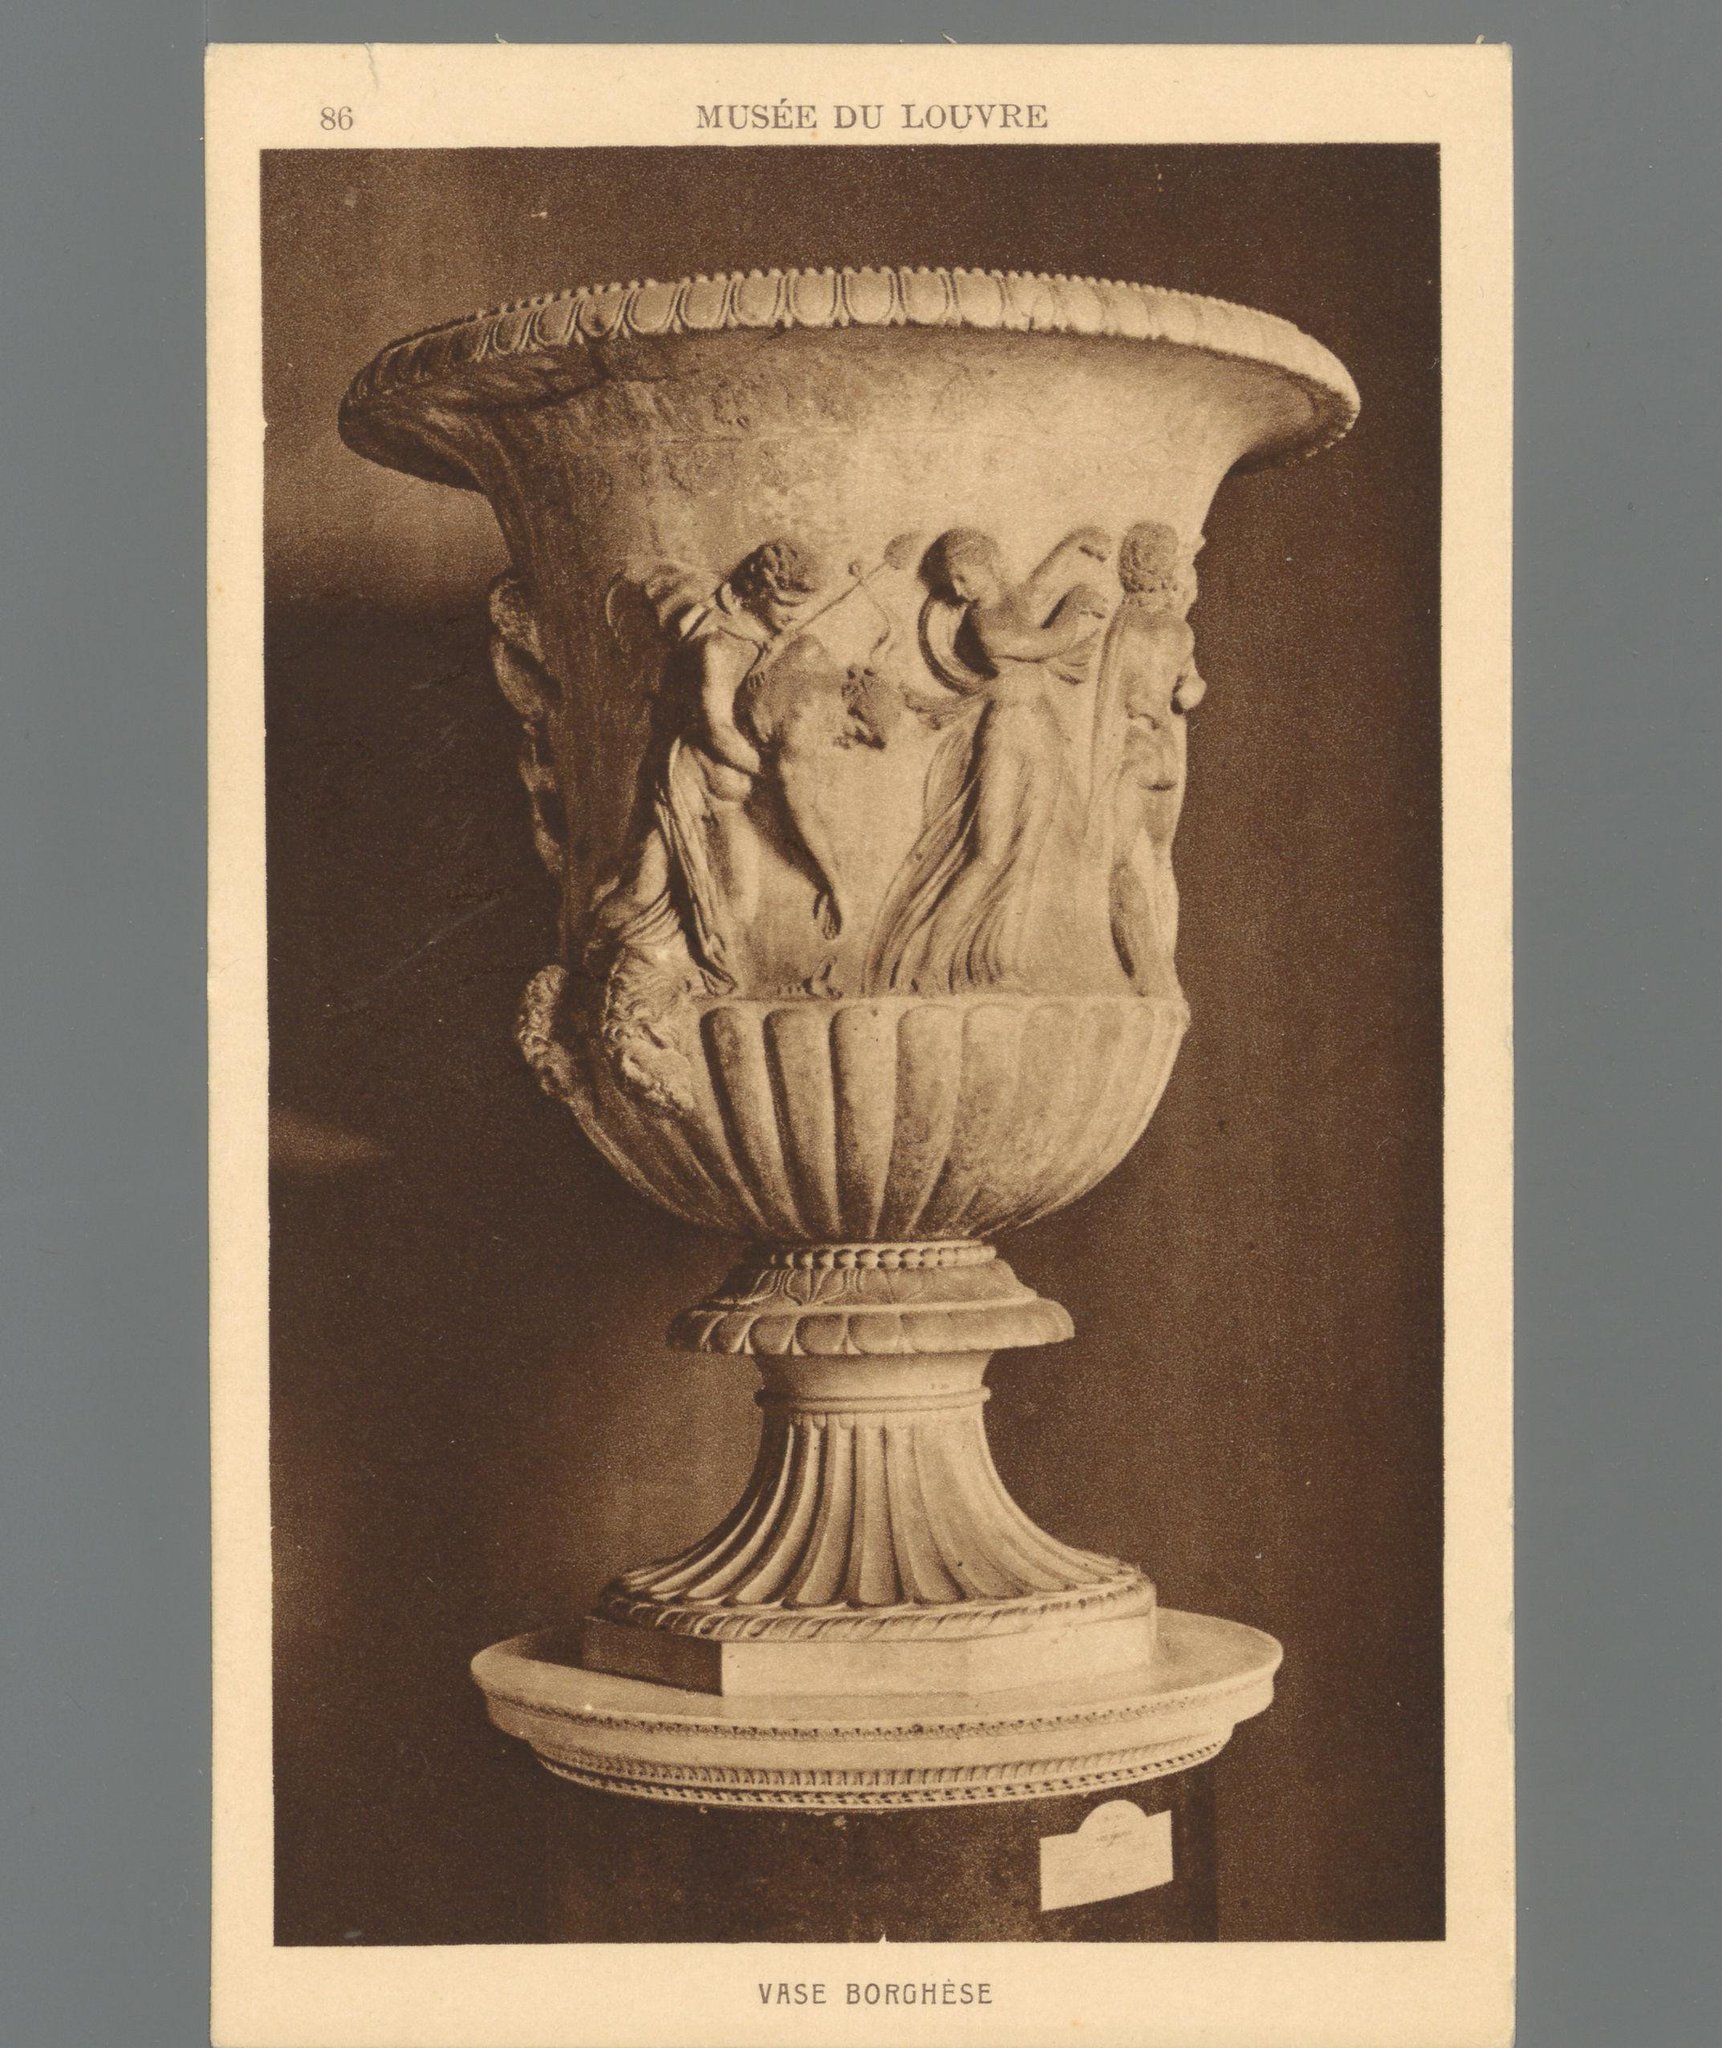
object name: ansichtkaart, prentbriefkaart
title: Musée du Louvre. Vase Borghèse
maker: Anonymous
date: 1903-1930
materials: cardboard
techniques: rotogravure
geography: paris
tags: vase ~ ornament, permanent exhibition, museum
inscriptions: collector's mark: ‘AFE v S’